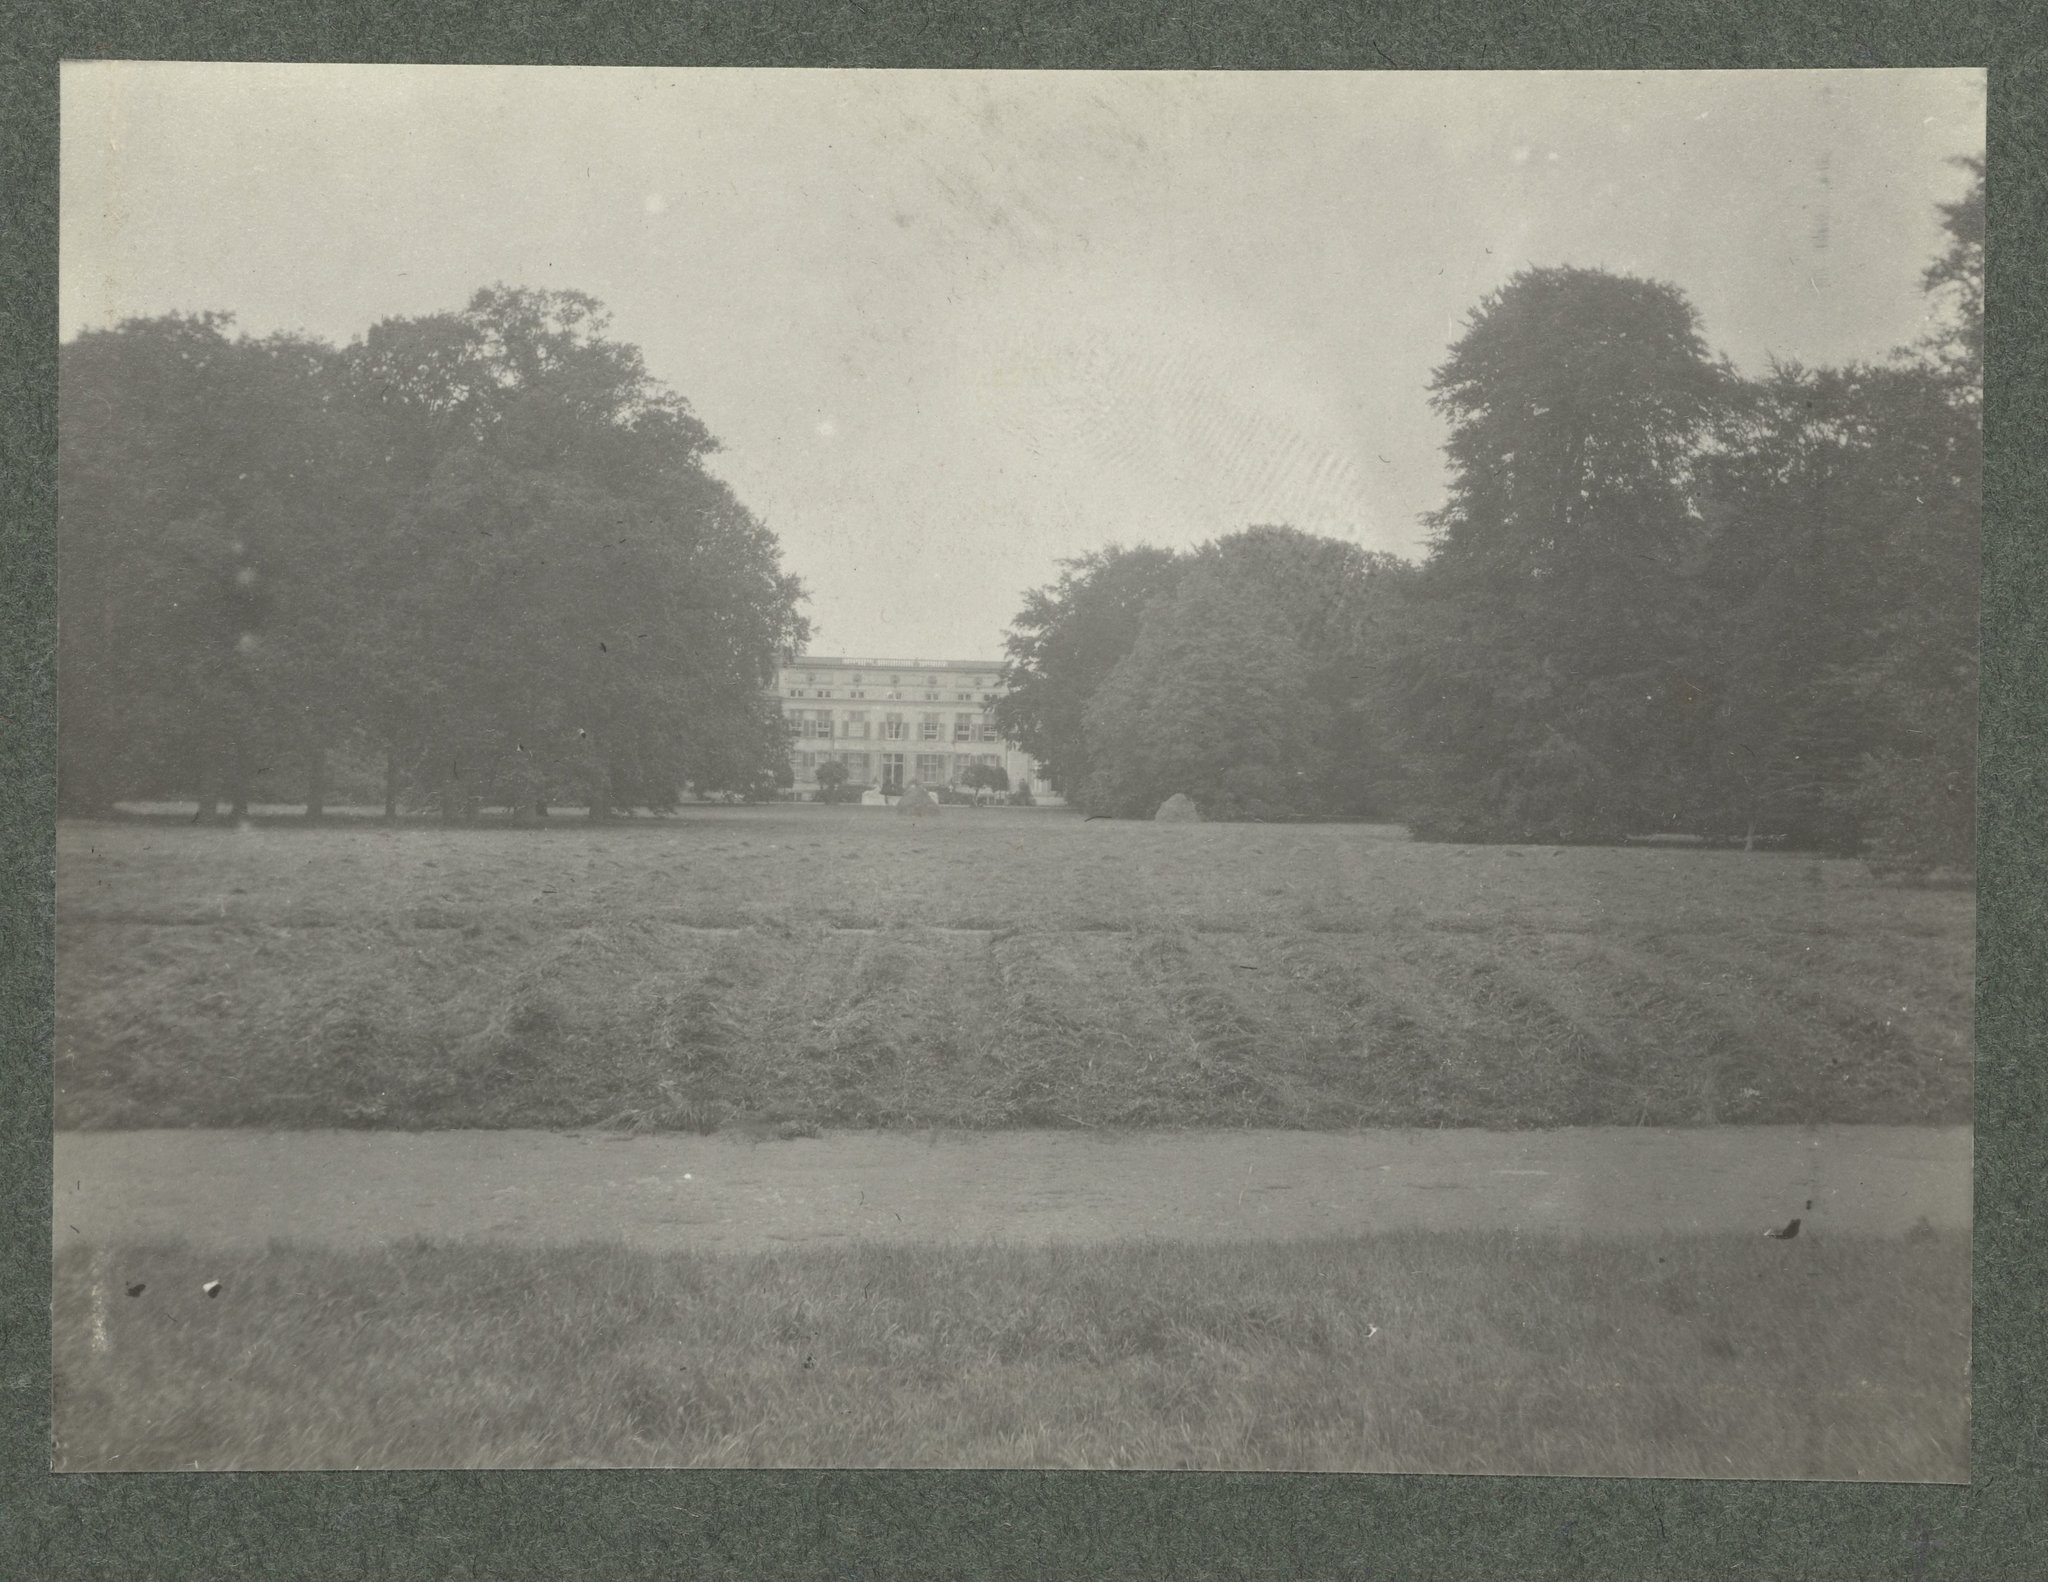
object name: photograph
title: Gezicht op landgoed De Pauw in Wassenaar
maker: geldolph adriaan kessler (dolph)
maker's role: fotograaf, industrieel, voetballer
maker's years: 1884-1945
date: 1913-1920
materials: paper, photographic support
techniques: gelatin silver print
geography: the hague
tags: huize de paauw